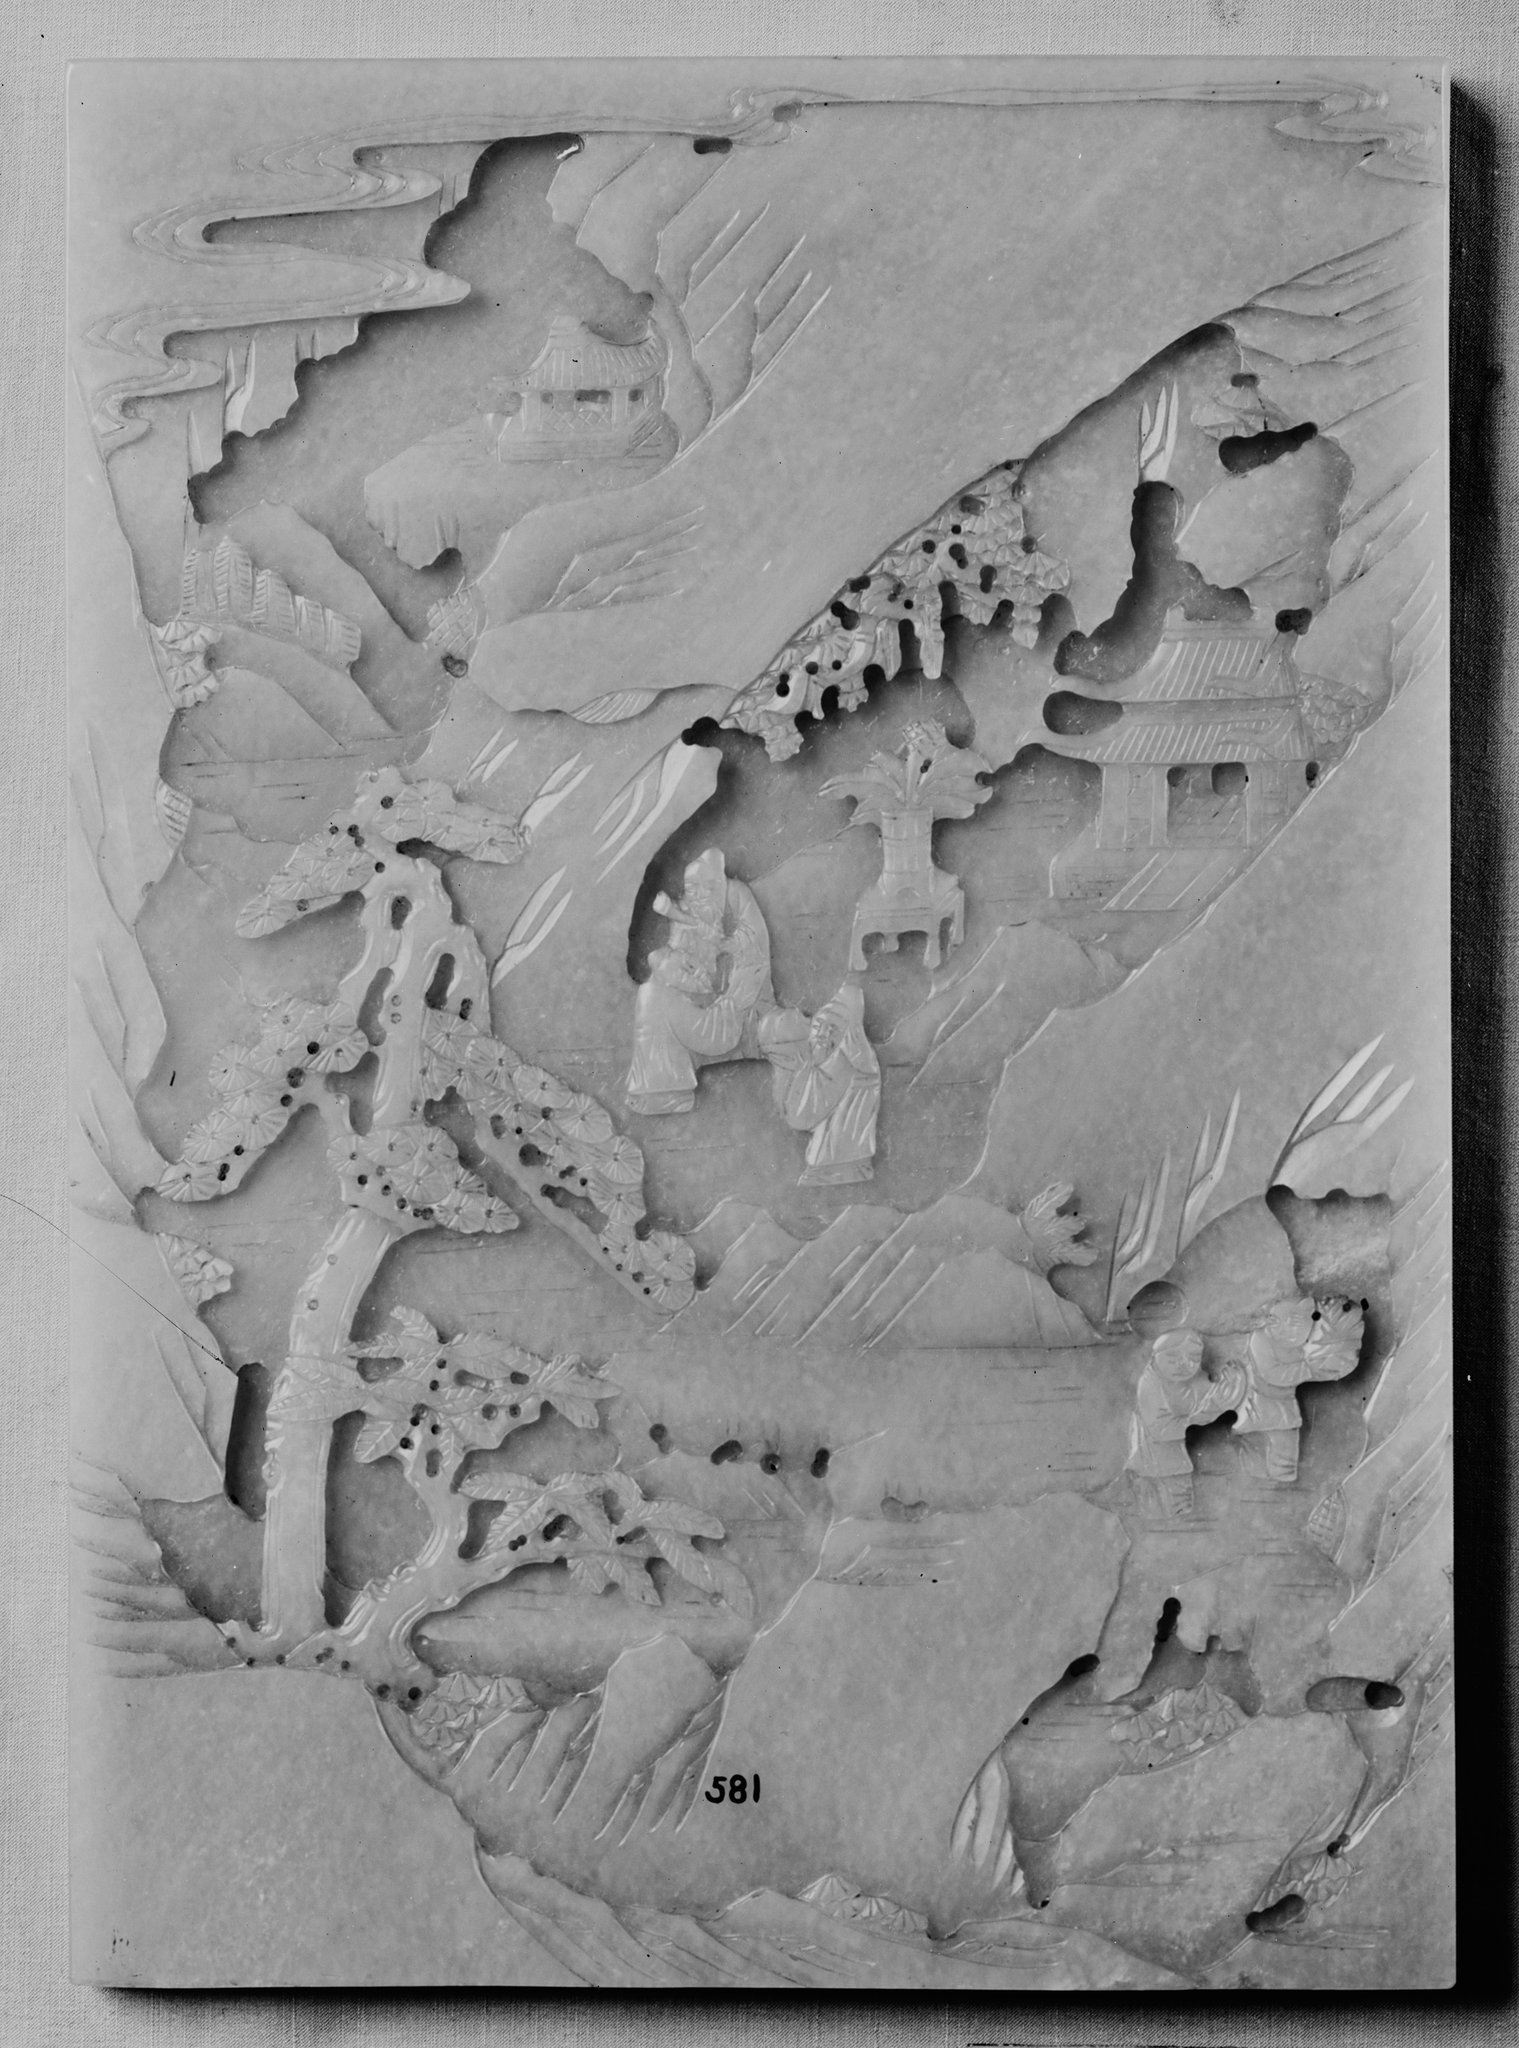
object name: table screen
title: Table screen with land of immortals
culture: chinese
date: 1701-1900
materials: jade